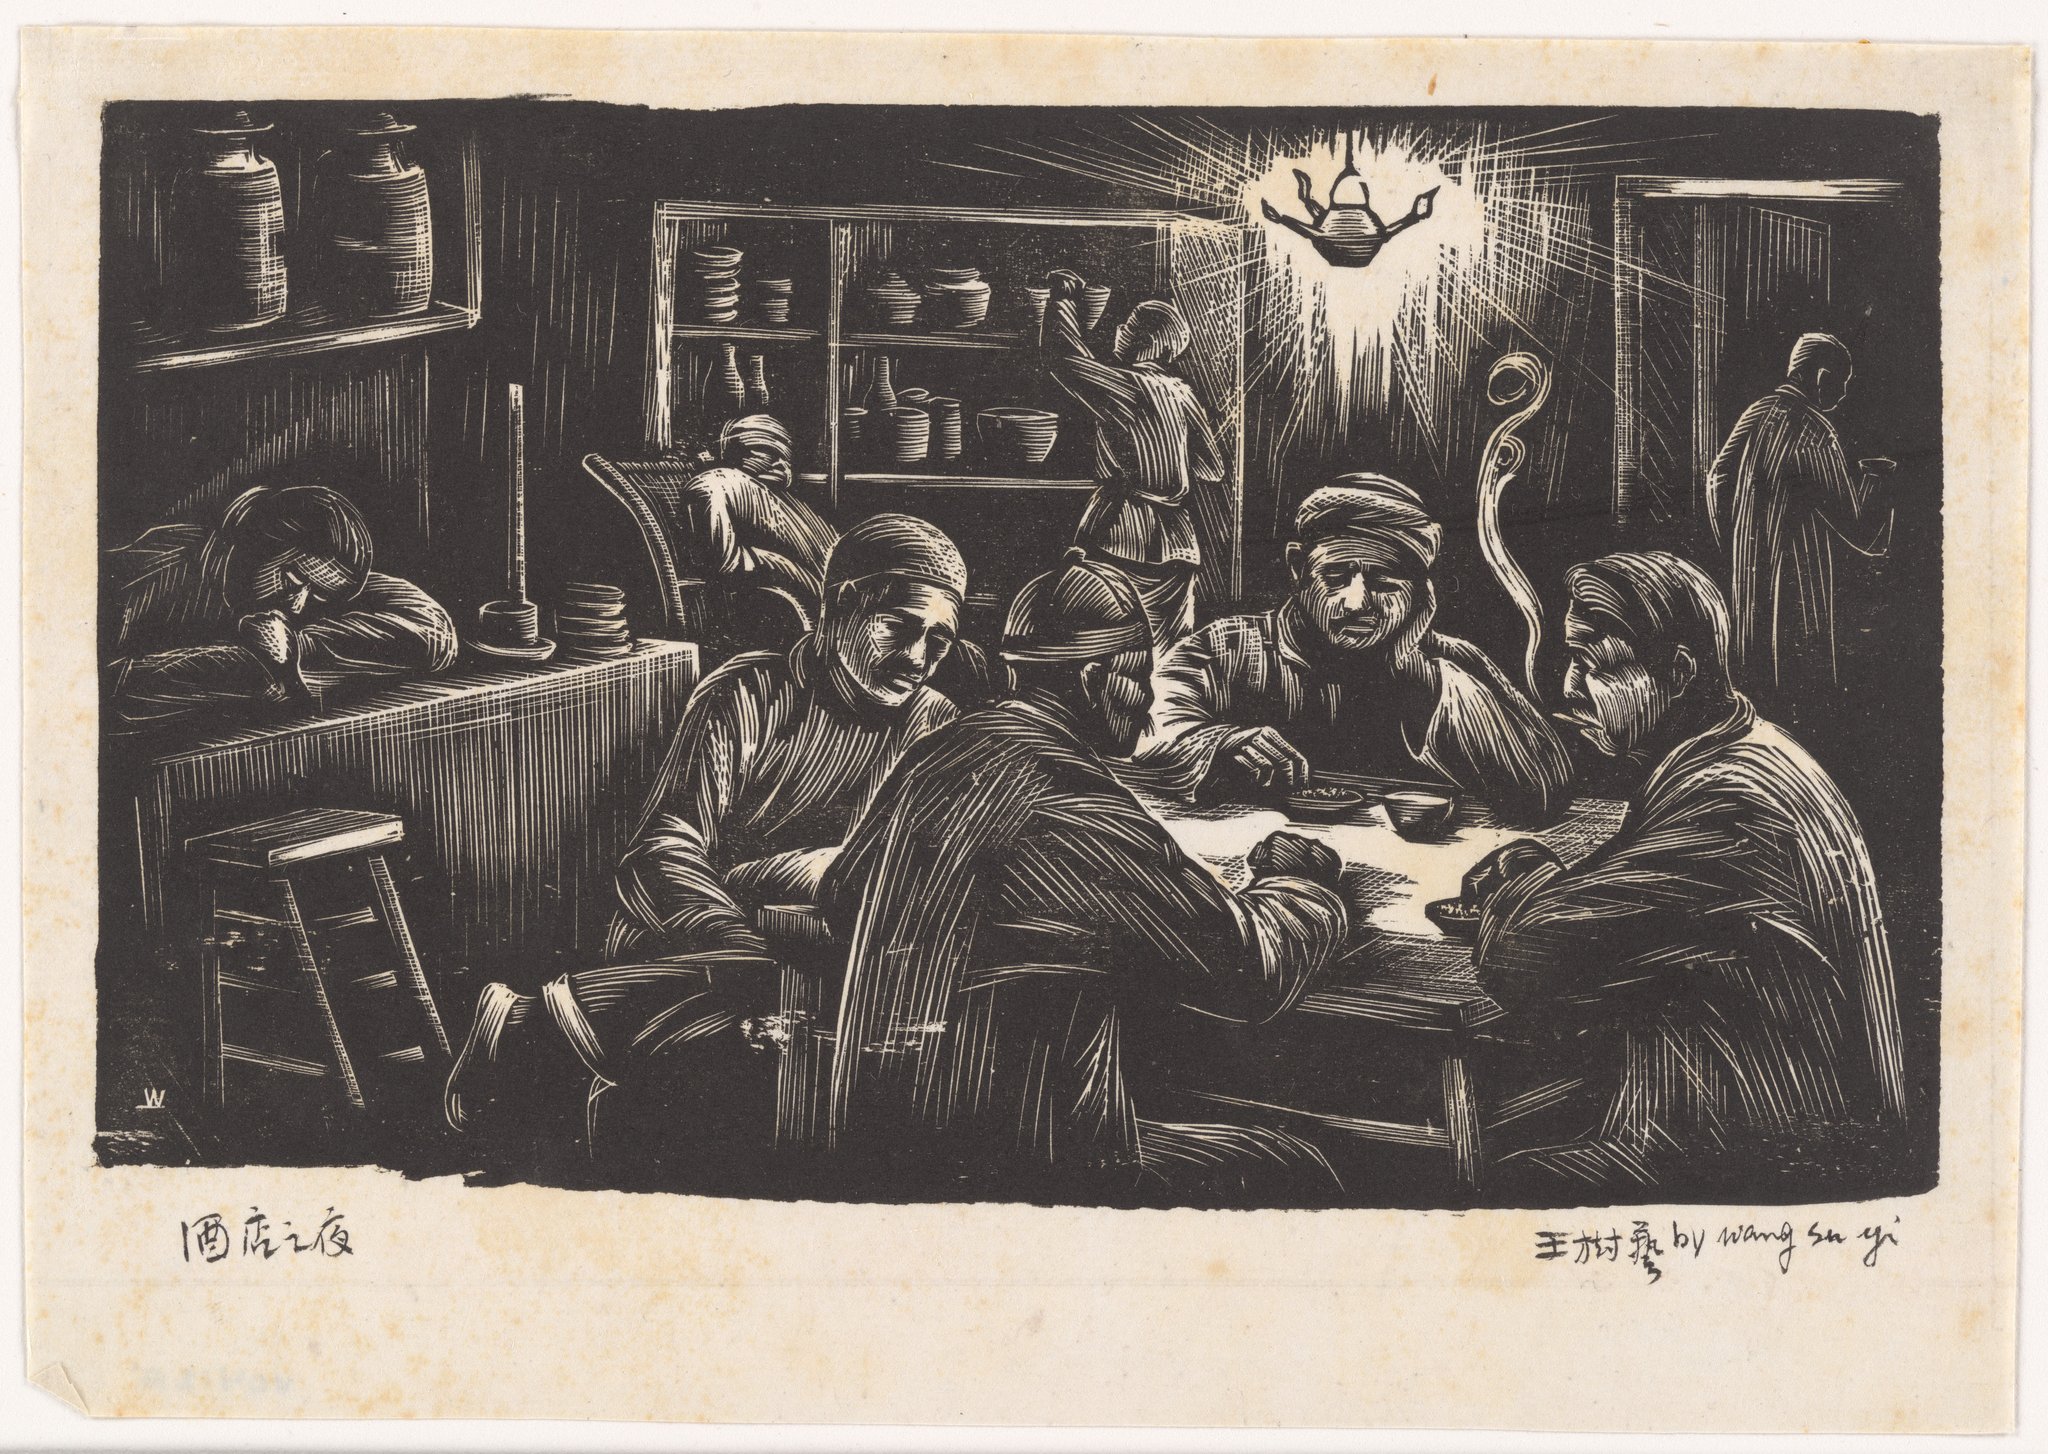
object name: woodcut, print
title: Evening in the Wine Shop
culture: chinese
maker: wang shuyi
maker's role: artist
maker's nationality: chinese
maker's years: 1916-1999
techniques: woodcut